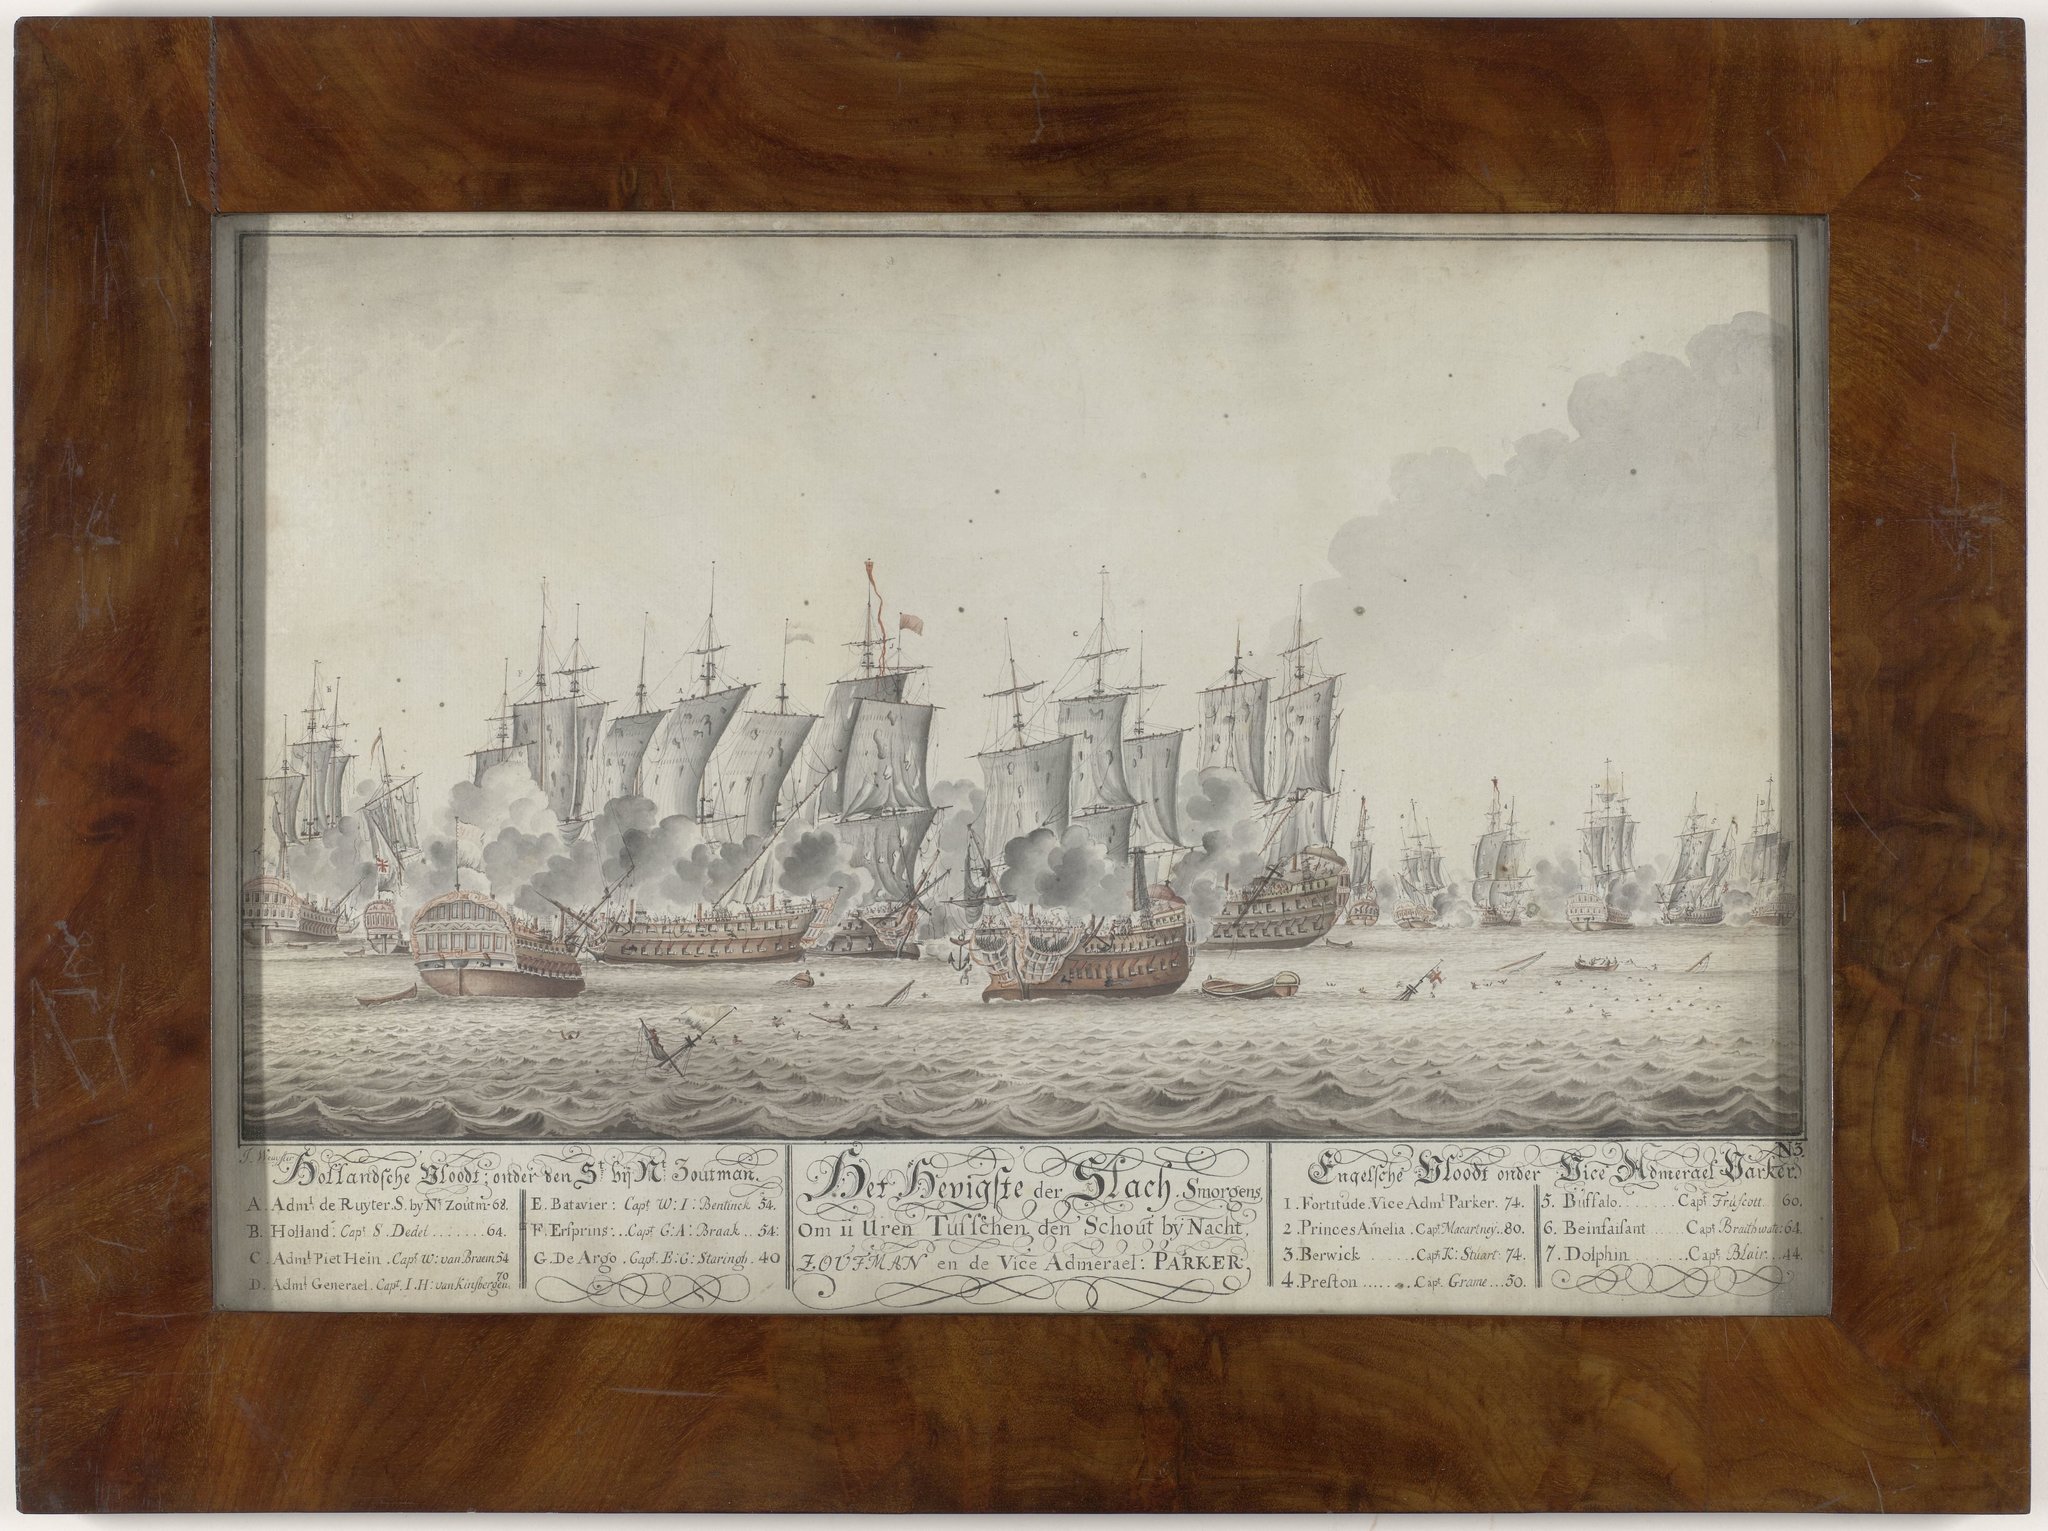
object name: drawing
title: The Action off Dogger Bank (5 August 1781)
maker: j. weuyster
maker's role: draughtsman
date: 1783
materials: glass, ink, wood, paper, watercolor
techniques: brush, pen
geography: netherlands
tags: the hague, johan arnold zoutman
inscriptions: signature, left: ‘J. Weuyster’, inscription, right: ‘N3.’, caption, bottom centre: ‘Het Hevigste der Slach Smorgens / om 11 Uren Tusschen den Schout bij Nacht / ZOUTMAN en de Vice Admerael PARKER’, inscription, bottom left and right: identification of the Dutch and British ships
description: Tekening met gecalligrafeerde titel. Centr. aantal schepen van verschillende zijden te zien, met kapotgeschoten zeilen en beschadigde masten en raas. Op voorgrond drijvende delen van schepen in het water, en her en der mensen. R. op achtergrond zijn ook schepen en rookwolken te zien. Bij masttoppen van schepen zijn letters en cijfers aangebracht, die corresponderen met beschrijving onder tekening.